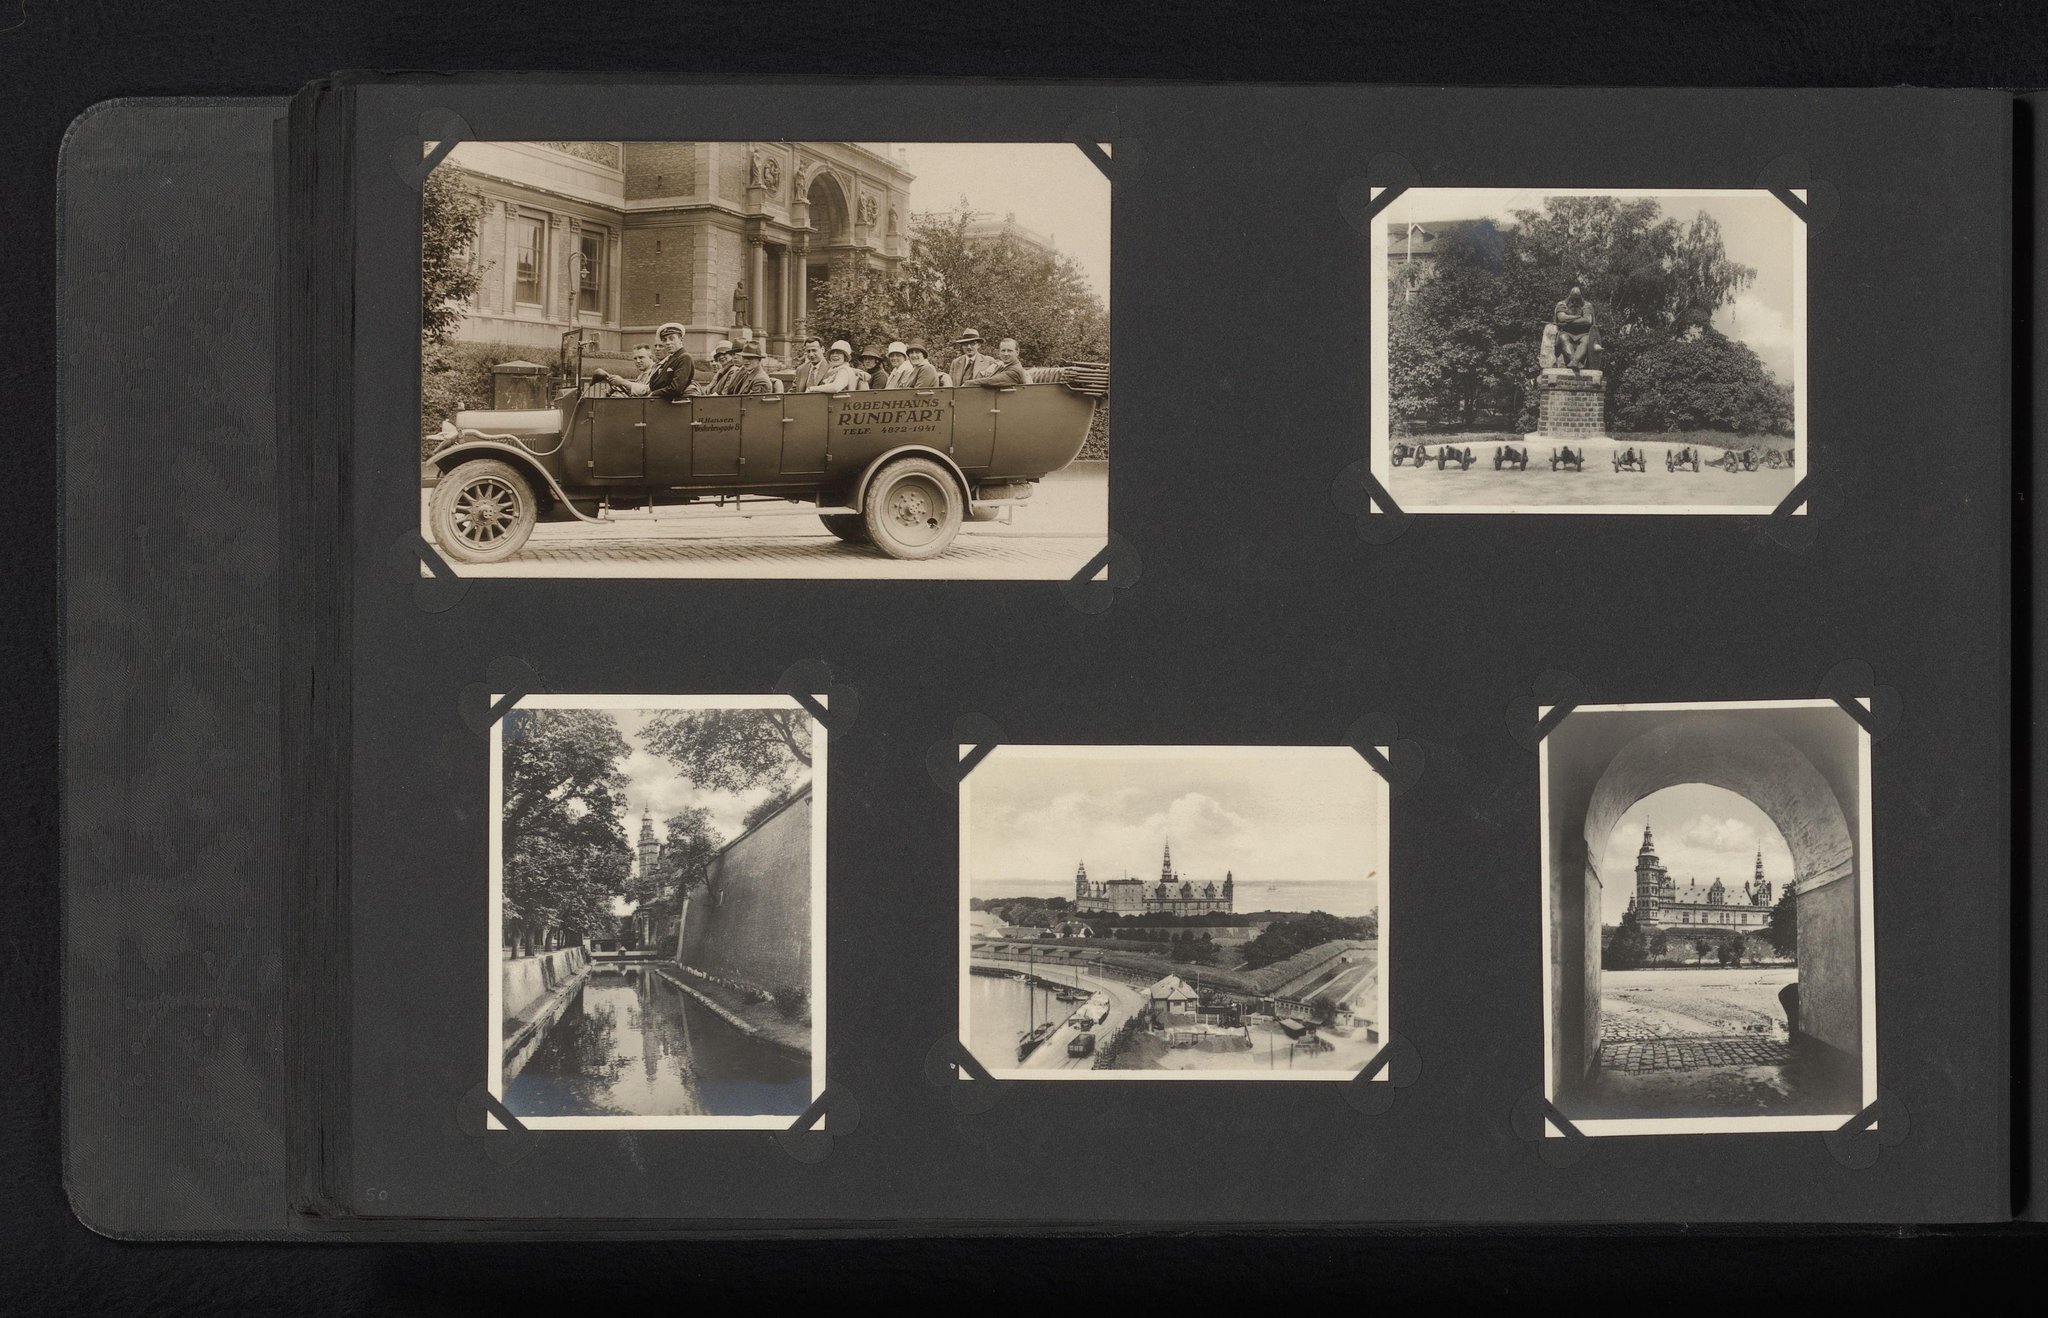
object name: album leaf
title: Vijf foto's van Kopenhagen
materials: paper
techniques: gelatin silver print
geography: copenhagen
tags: sightseeing, city-view in general; 'veduta', copenhagen (city)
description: Deze foto's maken deel uit van een album.